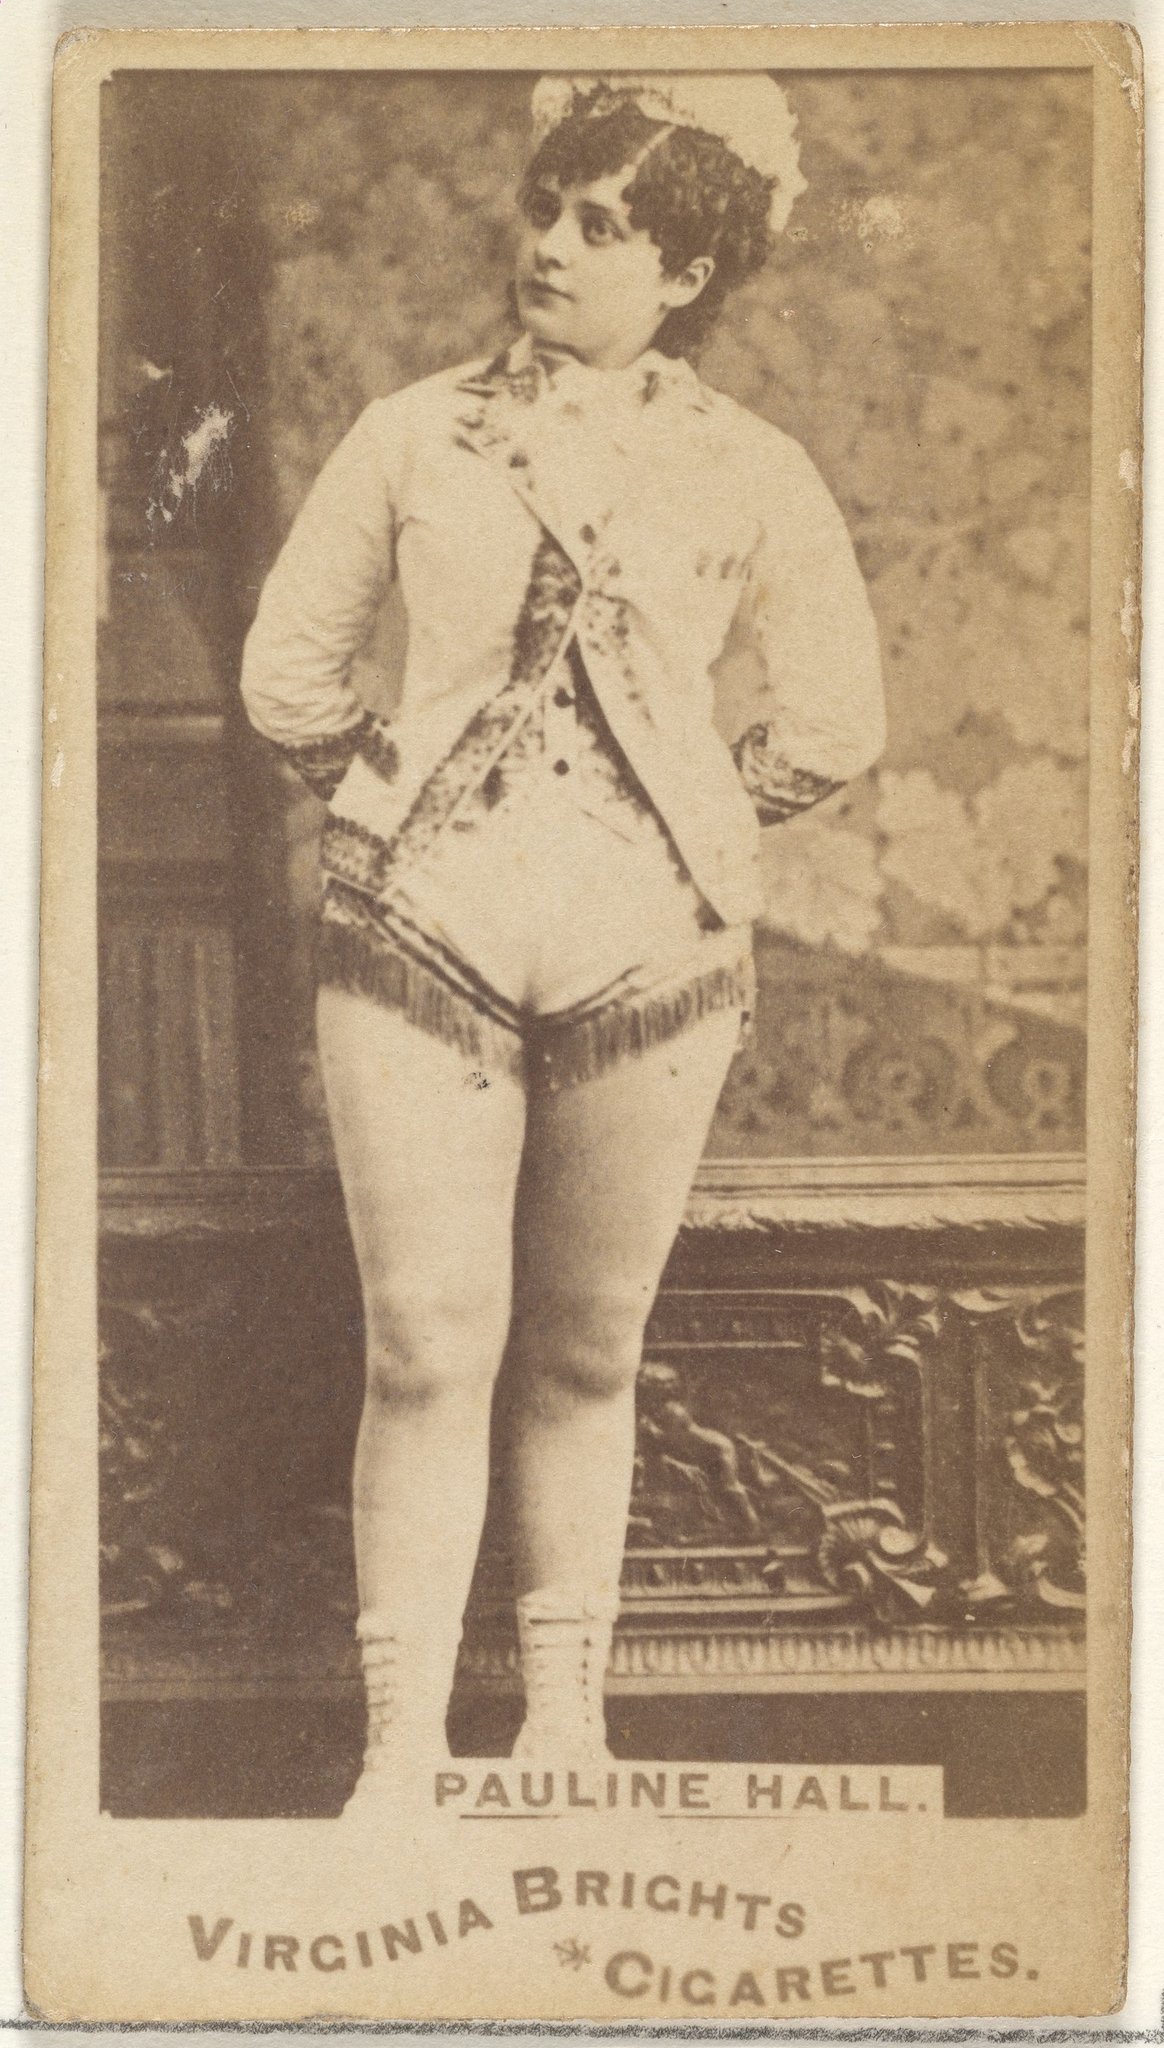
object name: photograph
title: Pauline Hall, from the Actors and Actresses series (N45, Type 1) for Virginia Brights Cigarettes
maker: allen & ginter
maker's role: publisher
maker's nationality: american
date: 1888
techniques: albumen silver print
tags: portraits,women,actresses